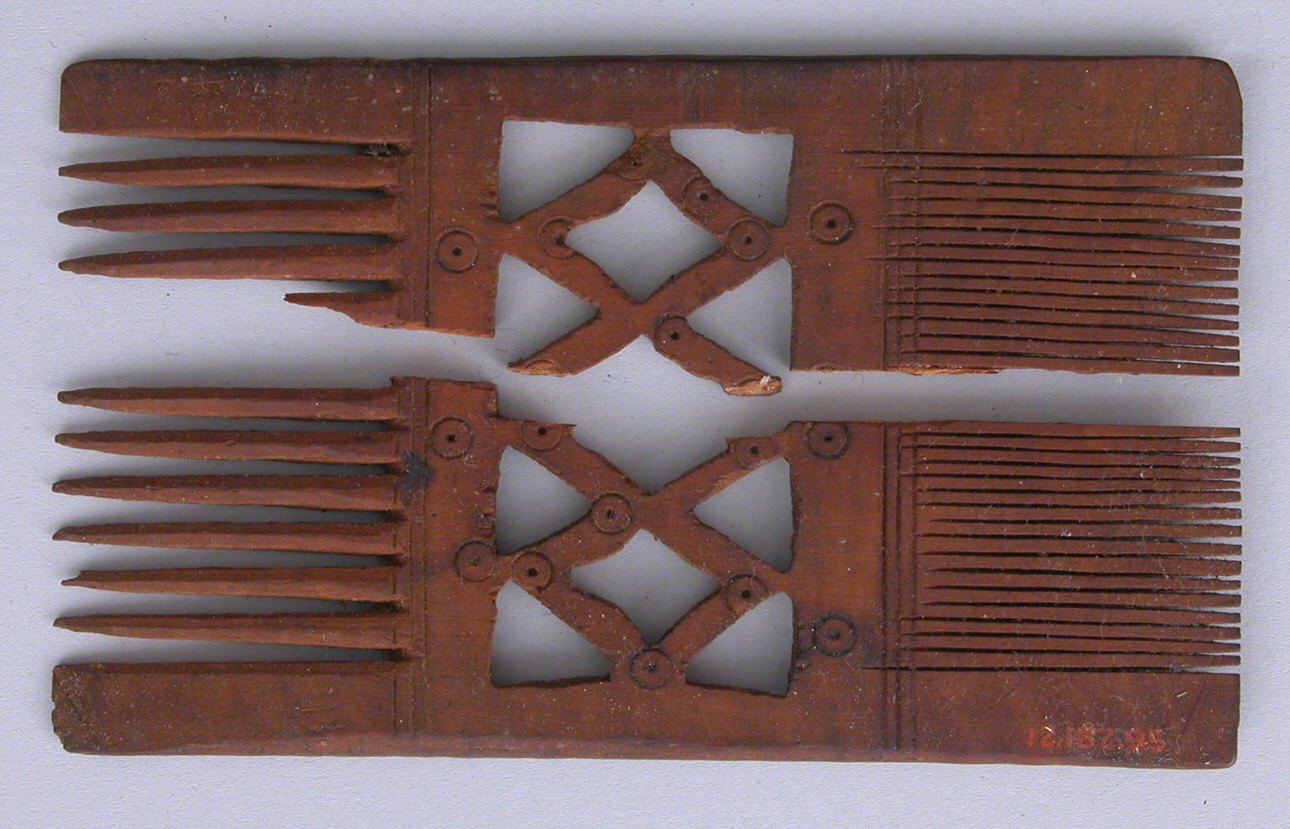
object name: comb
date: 601-800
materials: wood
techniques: carving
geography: egypt